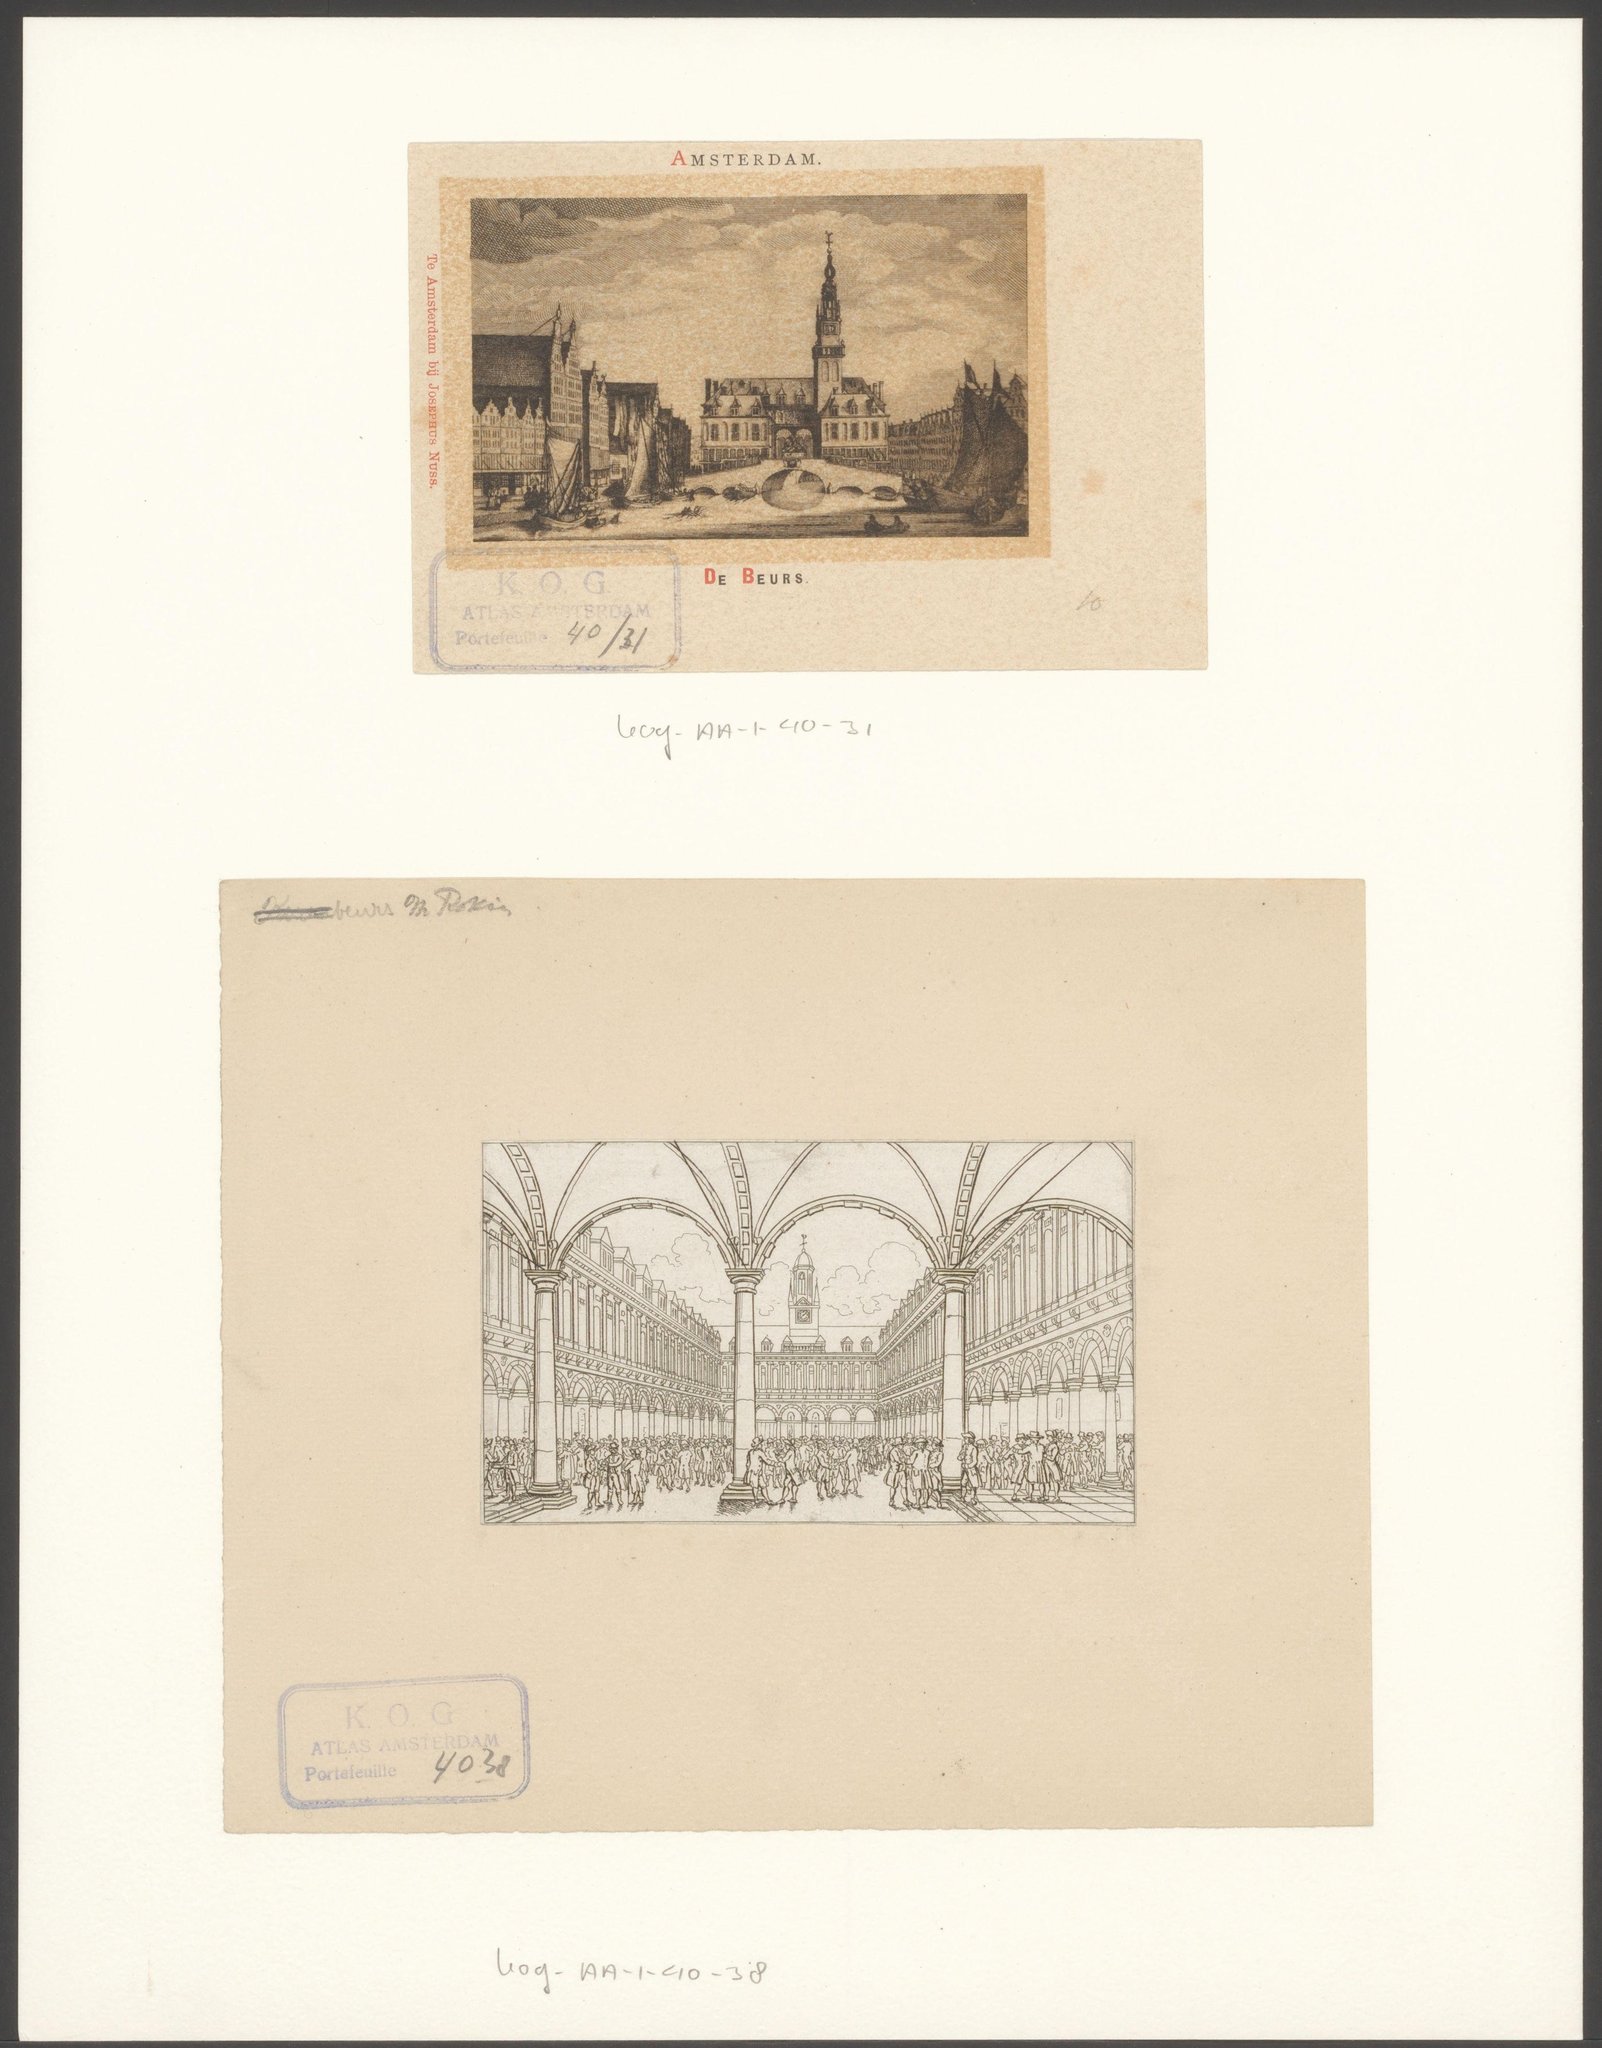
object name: print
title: Gezicht op de binnenplaats van de Beurs van Hendrik de Keyser te Amsterdam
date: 1824-1850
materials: paper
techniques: etching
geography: amsterdam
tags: stock exchange, stock-market, courtyard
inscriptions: collector's mark: Lugt 1641b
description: Onderwerpsrubriek binnen de Atlas Amsterdam: Handel en Zeevaart: Beurs op het Rokin.